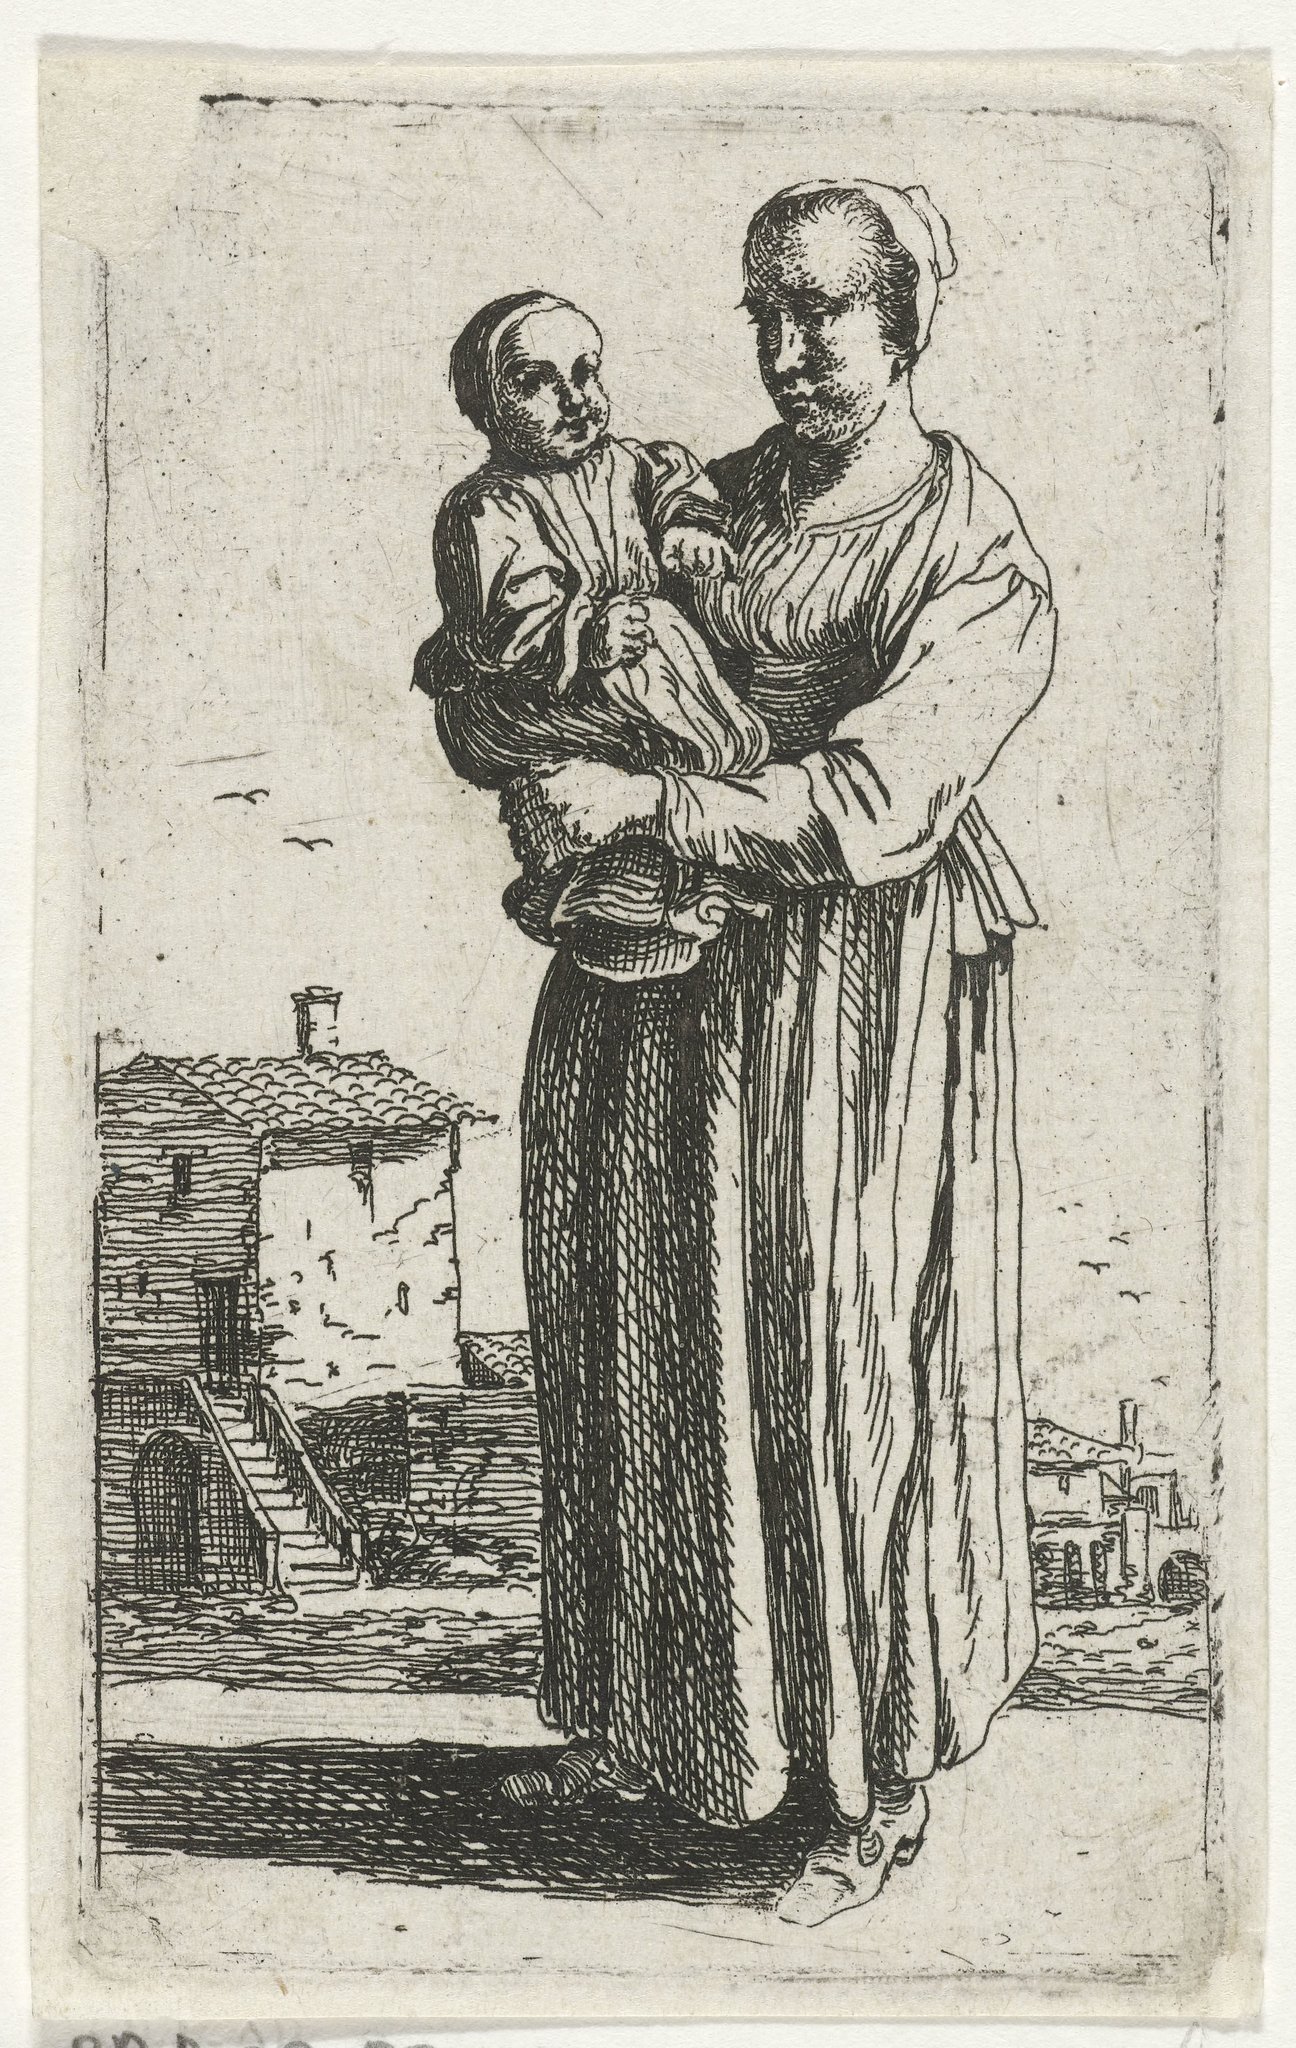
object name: print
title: Moeder en kind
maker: jan van den hecke (ii)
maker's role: print maker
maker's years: 1661-1722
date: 1671-1710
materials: paper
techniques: etching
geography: southern netherlands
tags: mother and baby or young child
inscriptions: collector's mark: Lugt 2228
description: Moeder en kind staand naar links, op de achtergrond enkele huizen.